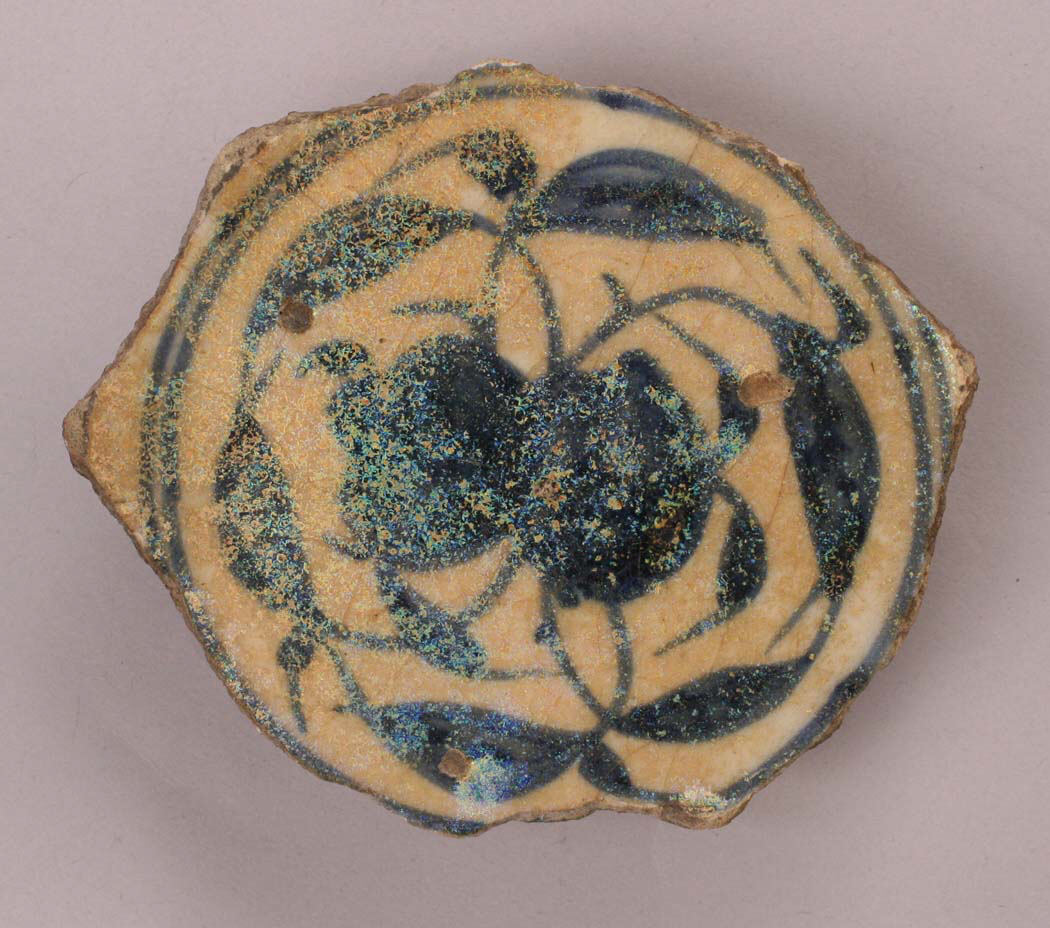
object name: fragment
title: Fragment of a Bowl or Cup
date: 1201-1600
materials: glaze, stonepaste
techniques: painting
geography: egypt